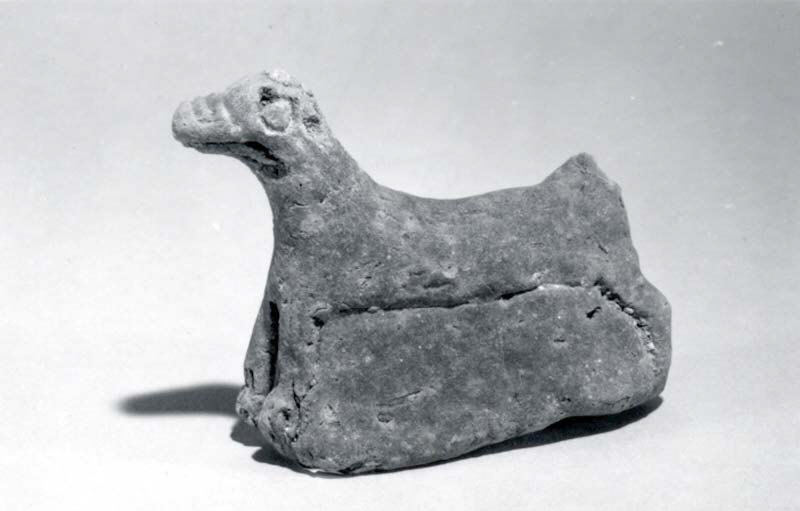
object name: sculpture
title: Figurine of animal (dog or mushhushshu)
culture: assyrian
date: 634-601 BCE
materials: ceramic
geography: mesopotamia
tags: dogs